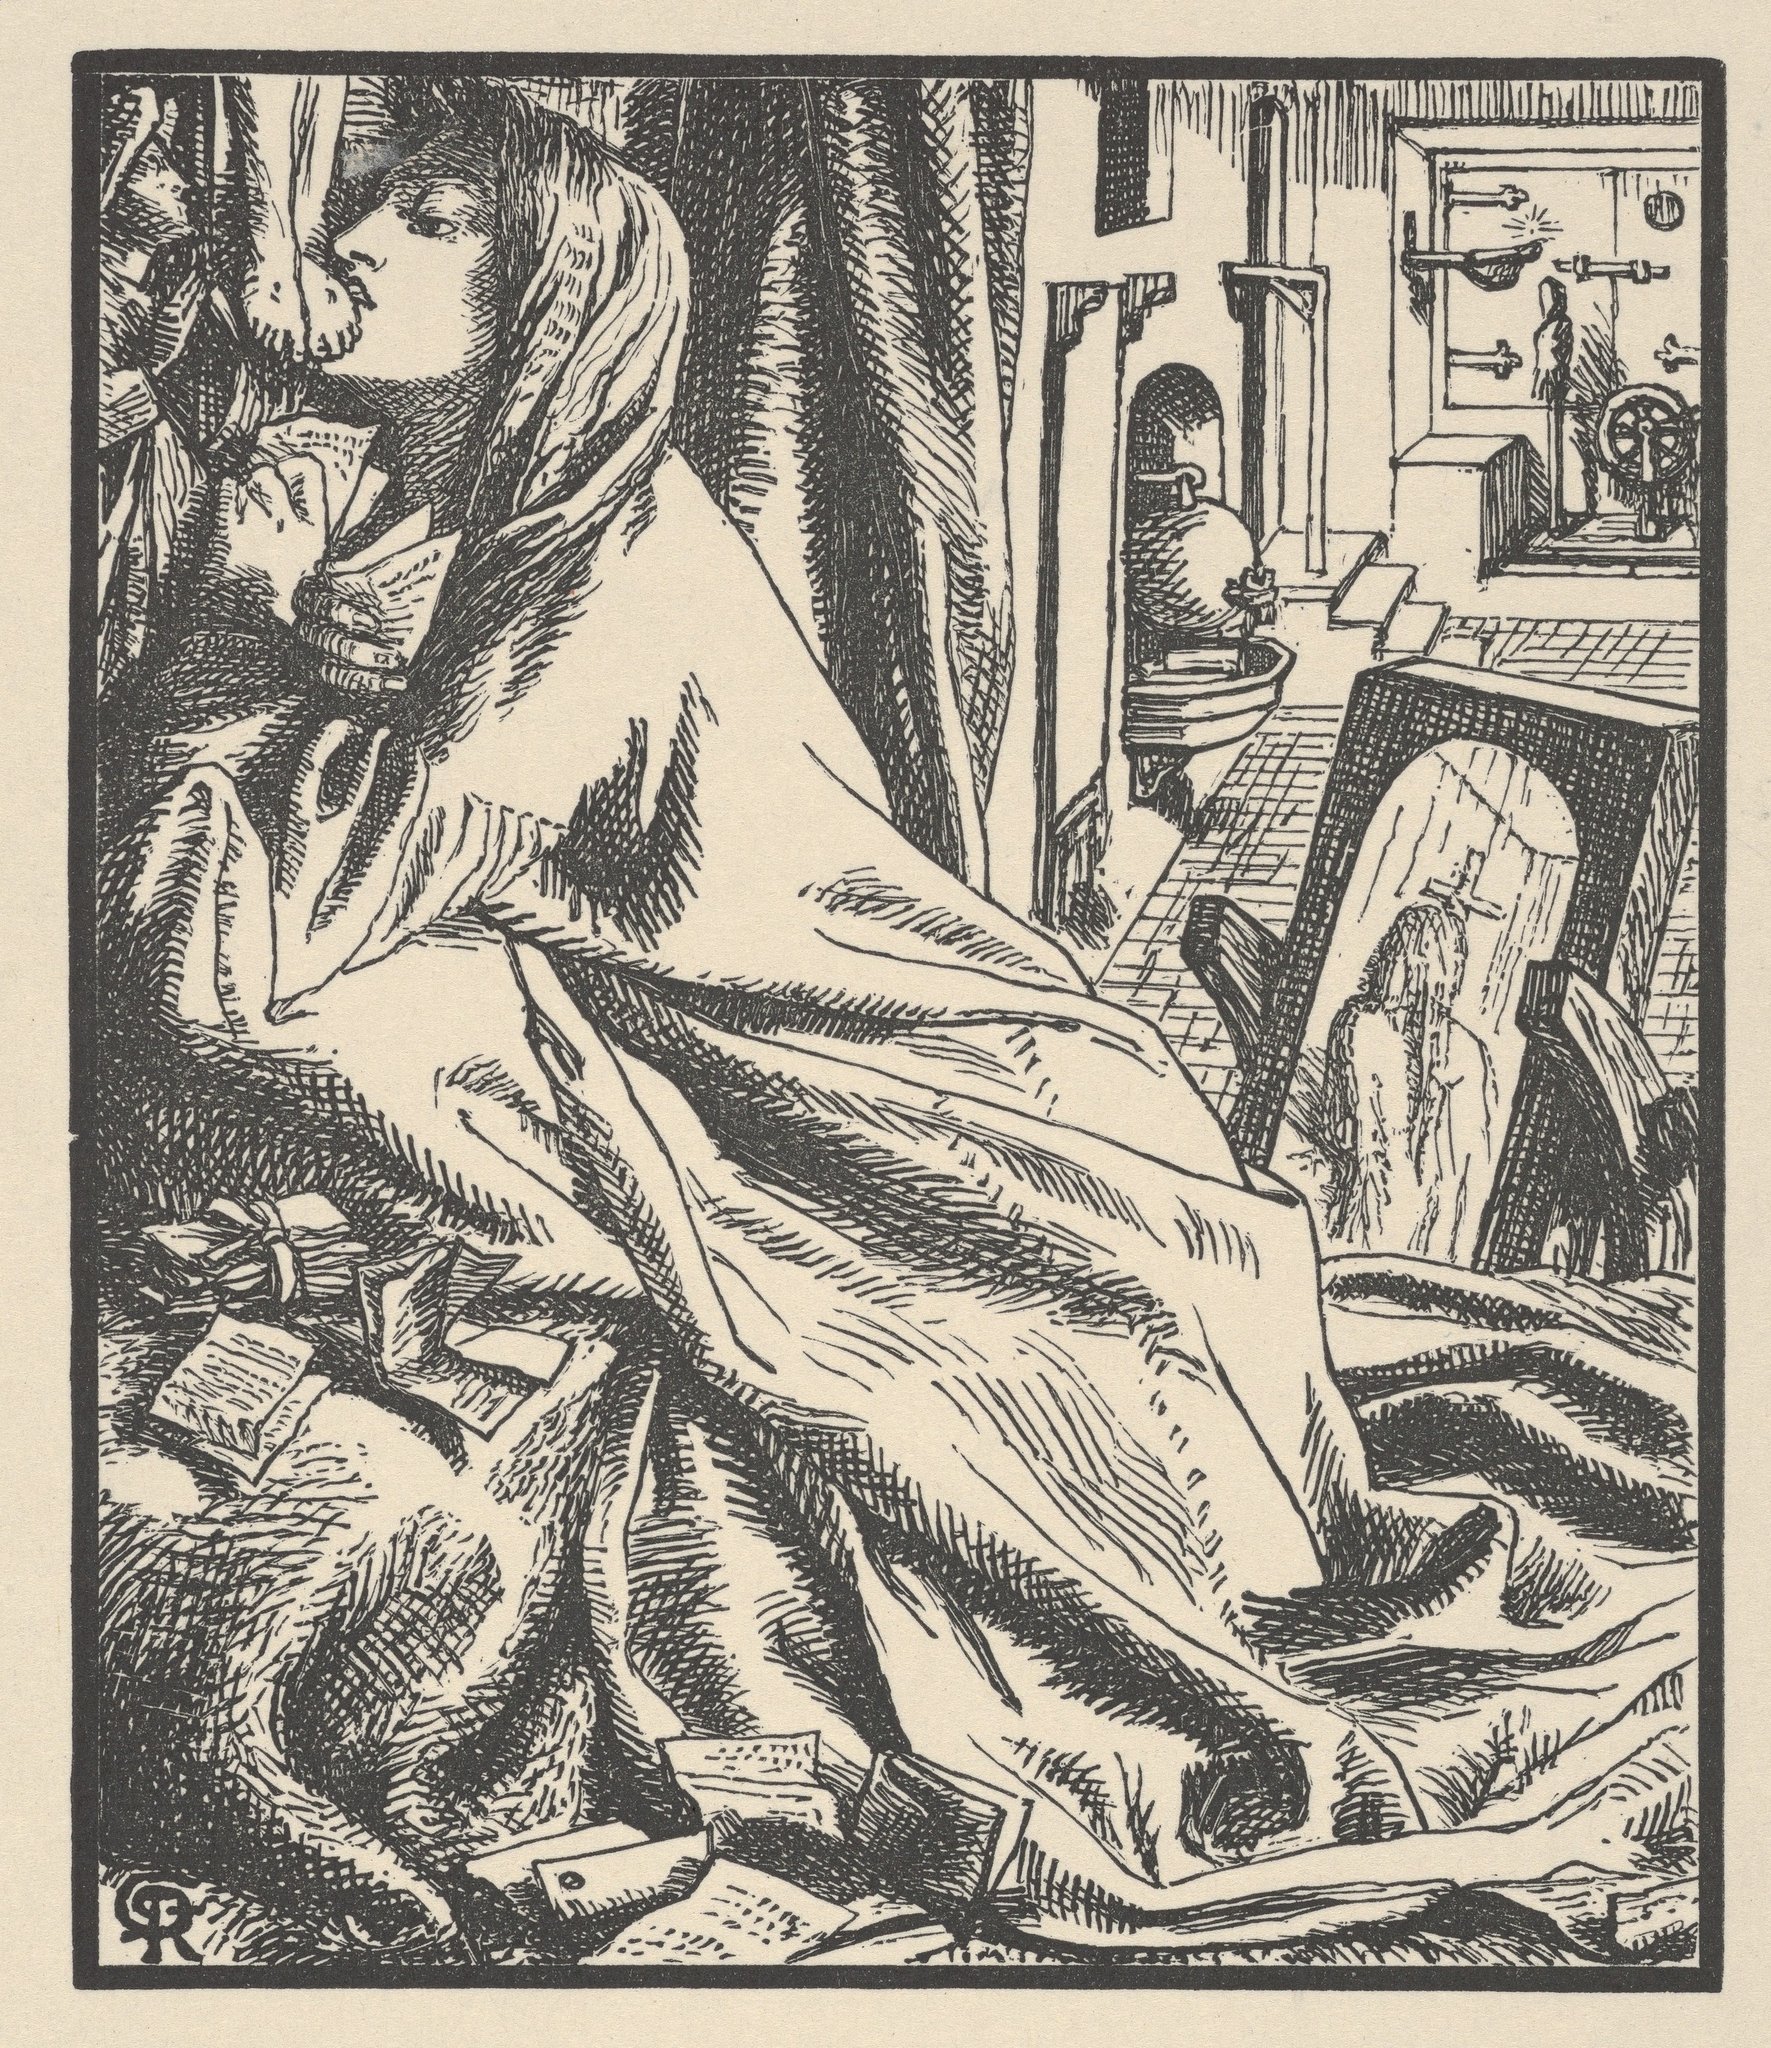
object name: print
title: Mariana in the South (Illustration for "The Palace of Art" in Tennyson's Poems, New York, 1903)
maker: dante gabriel rossetti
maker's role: artist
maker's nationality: british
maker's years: 1828-1882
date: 1857-1903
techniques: engraving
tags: women,cross,mirrors